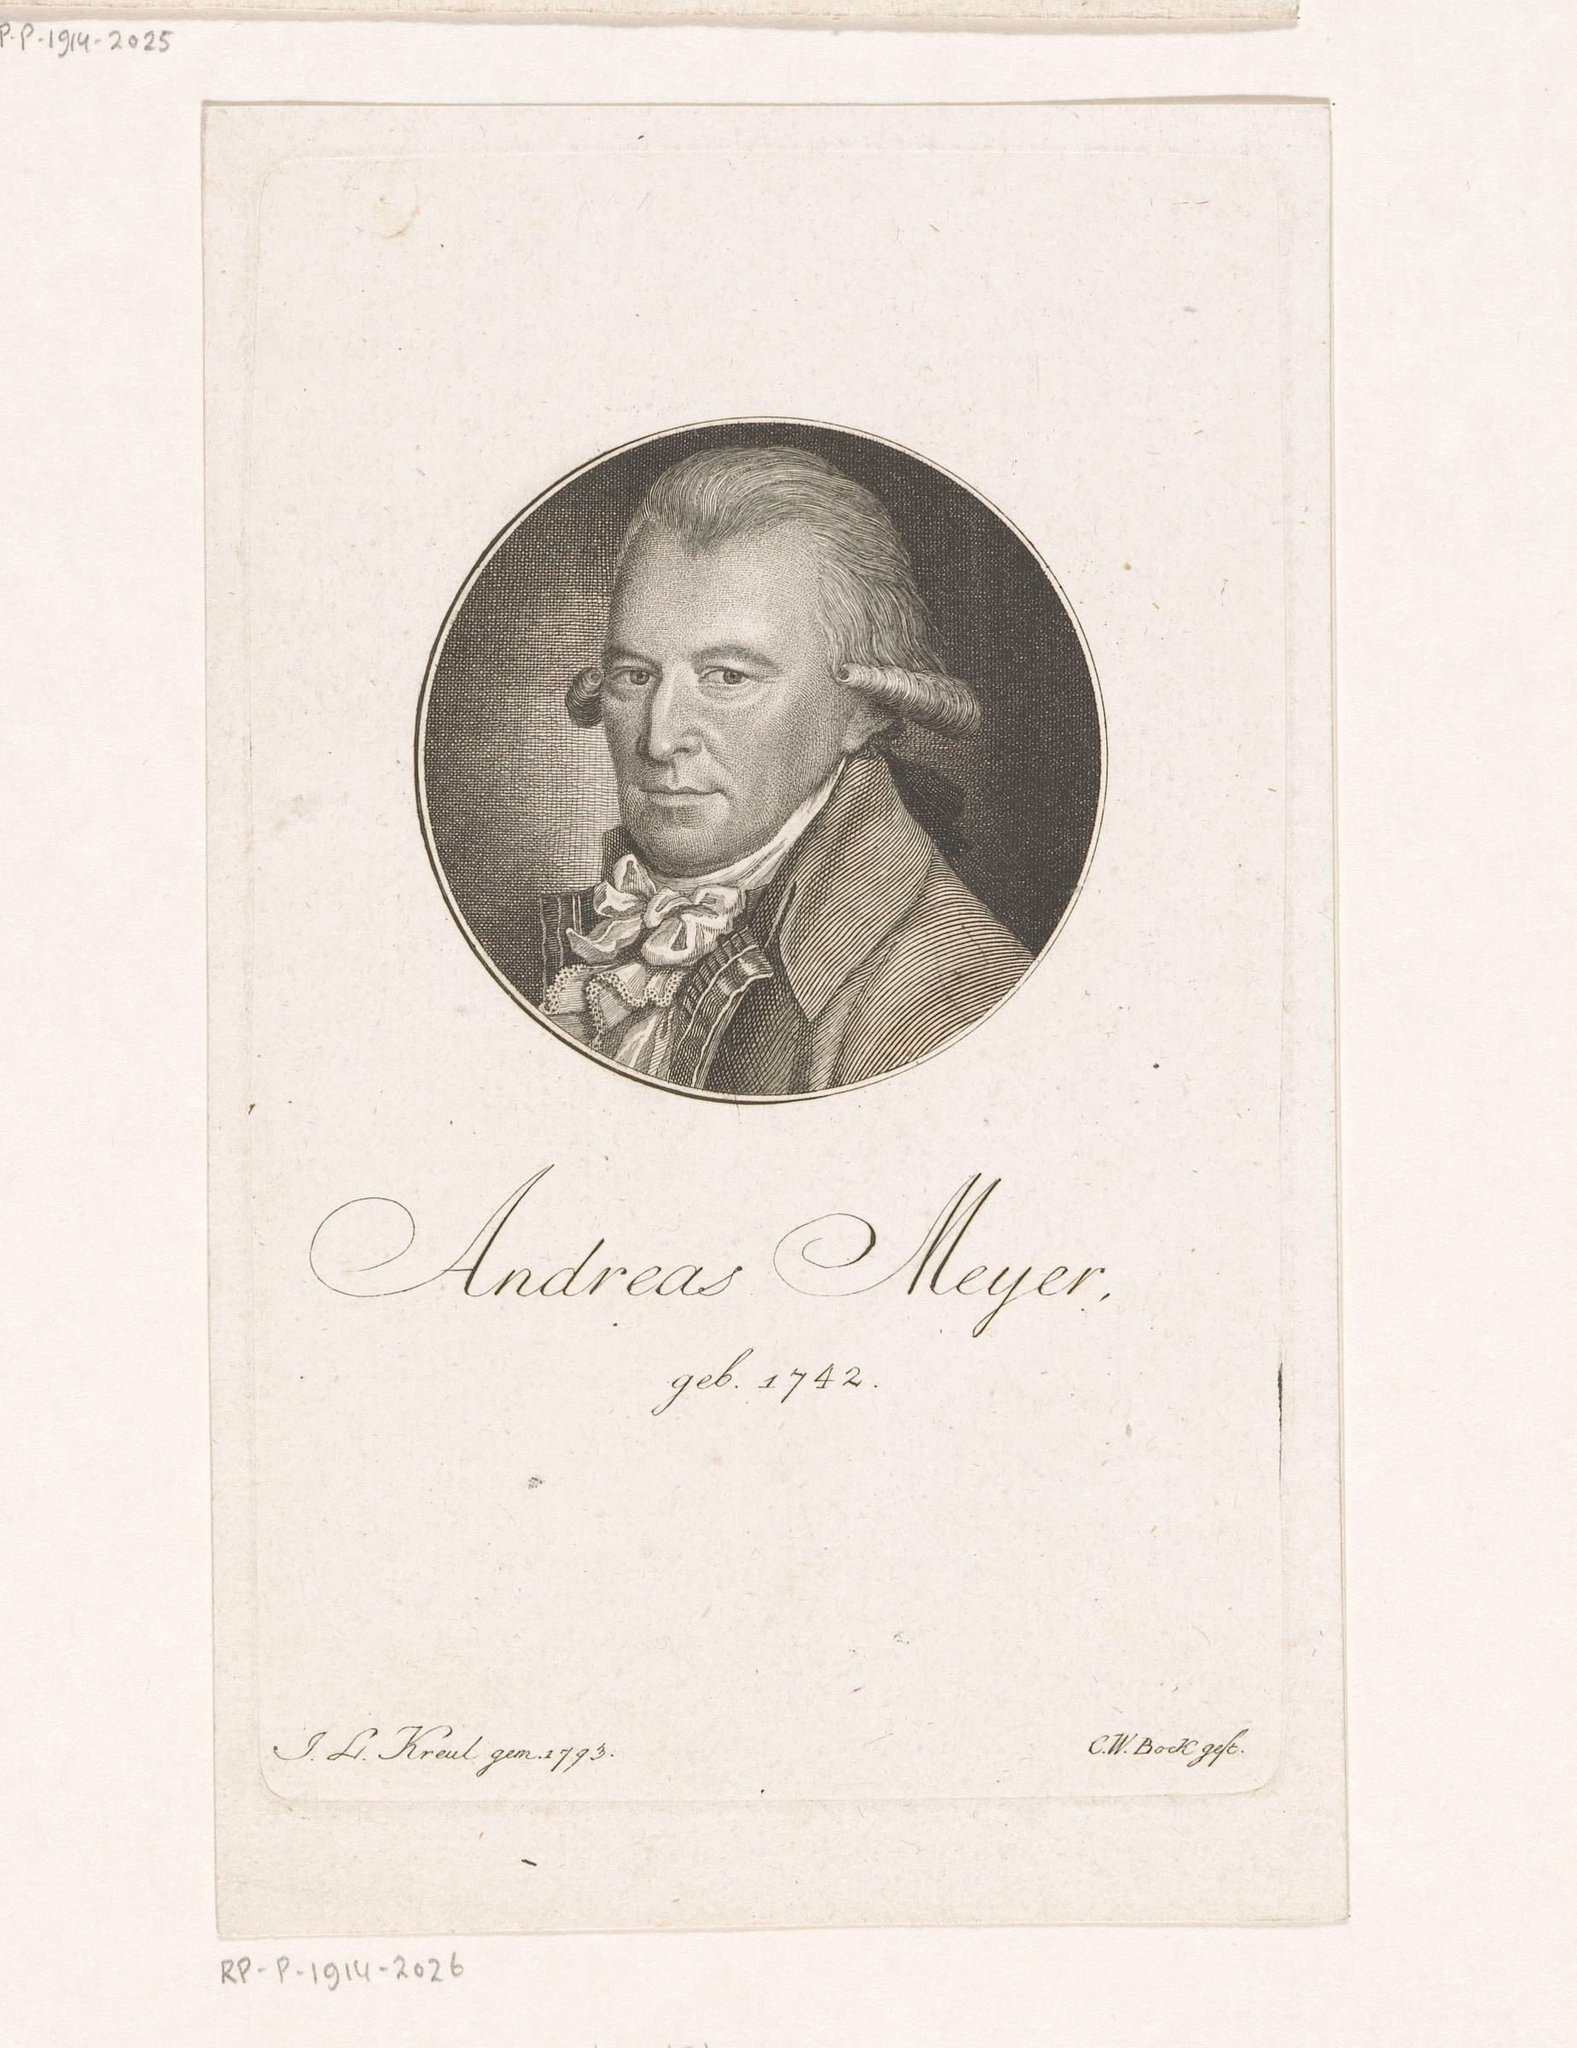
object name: print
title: Portret van Andreas Meyer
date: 1793-1807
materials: paper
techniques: engraving, etching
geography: nuremberg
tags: historical persons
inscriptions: collector's mark: Lugt 2228